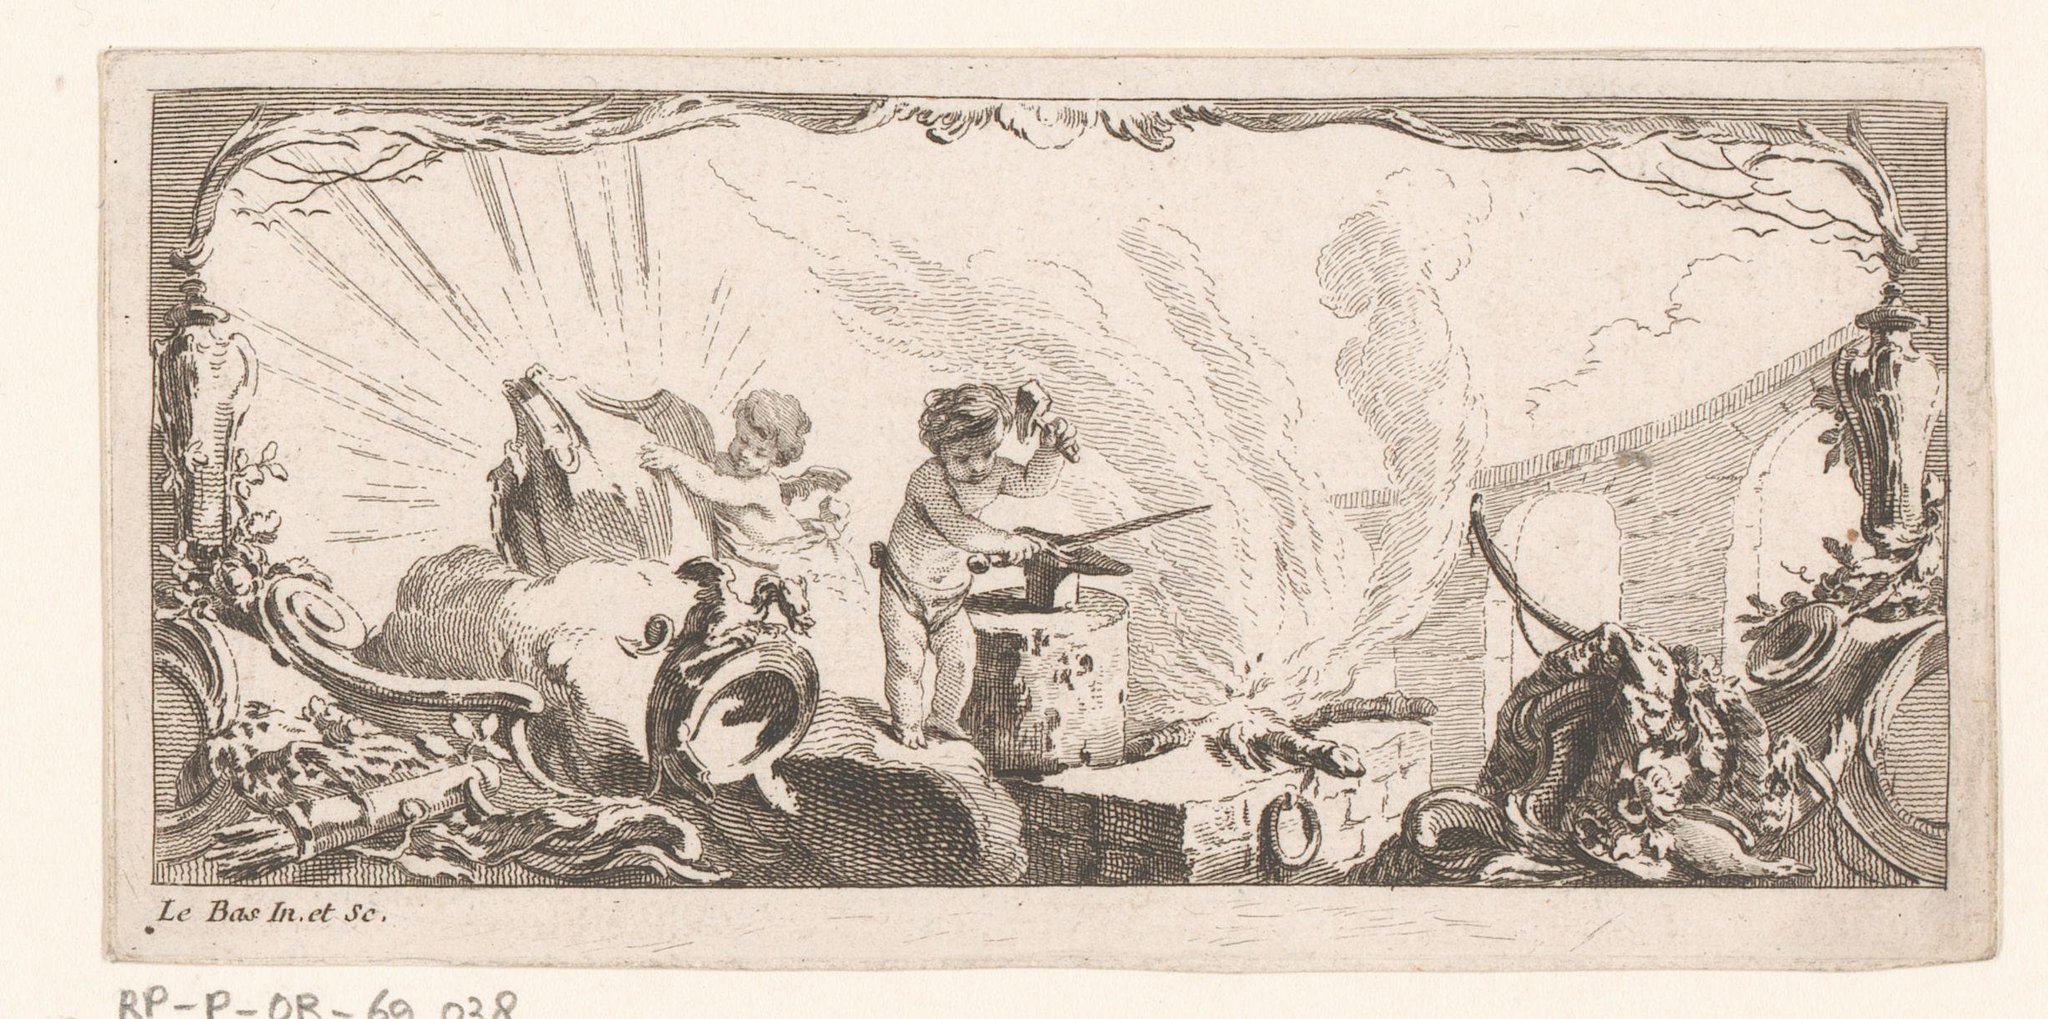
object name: print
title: Vignet met twee putti een kuras en zwaard smedend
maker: jacques-philippe le bas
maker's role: draughtsman, print maker, publisher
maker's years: 1707-1783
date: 1717-1783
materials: paper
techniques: etching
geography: paris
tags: cuirass, hacking and thrusting weapons: sword, handicrafts ~ metal, vignette, cupids: 'amores', 'amoretti', 'putti'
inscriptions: collector's mark: Lugt 2228